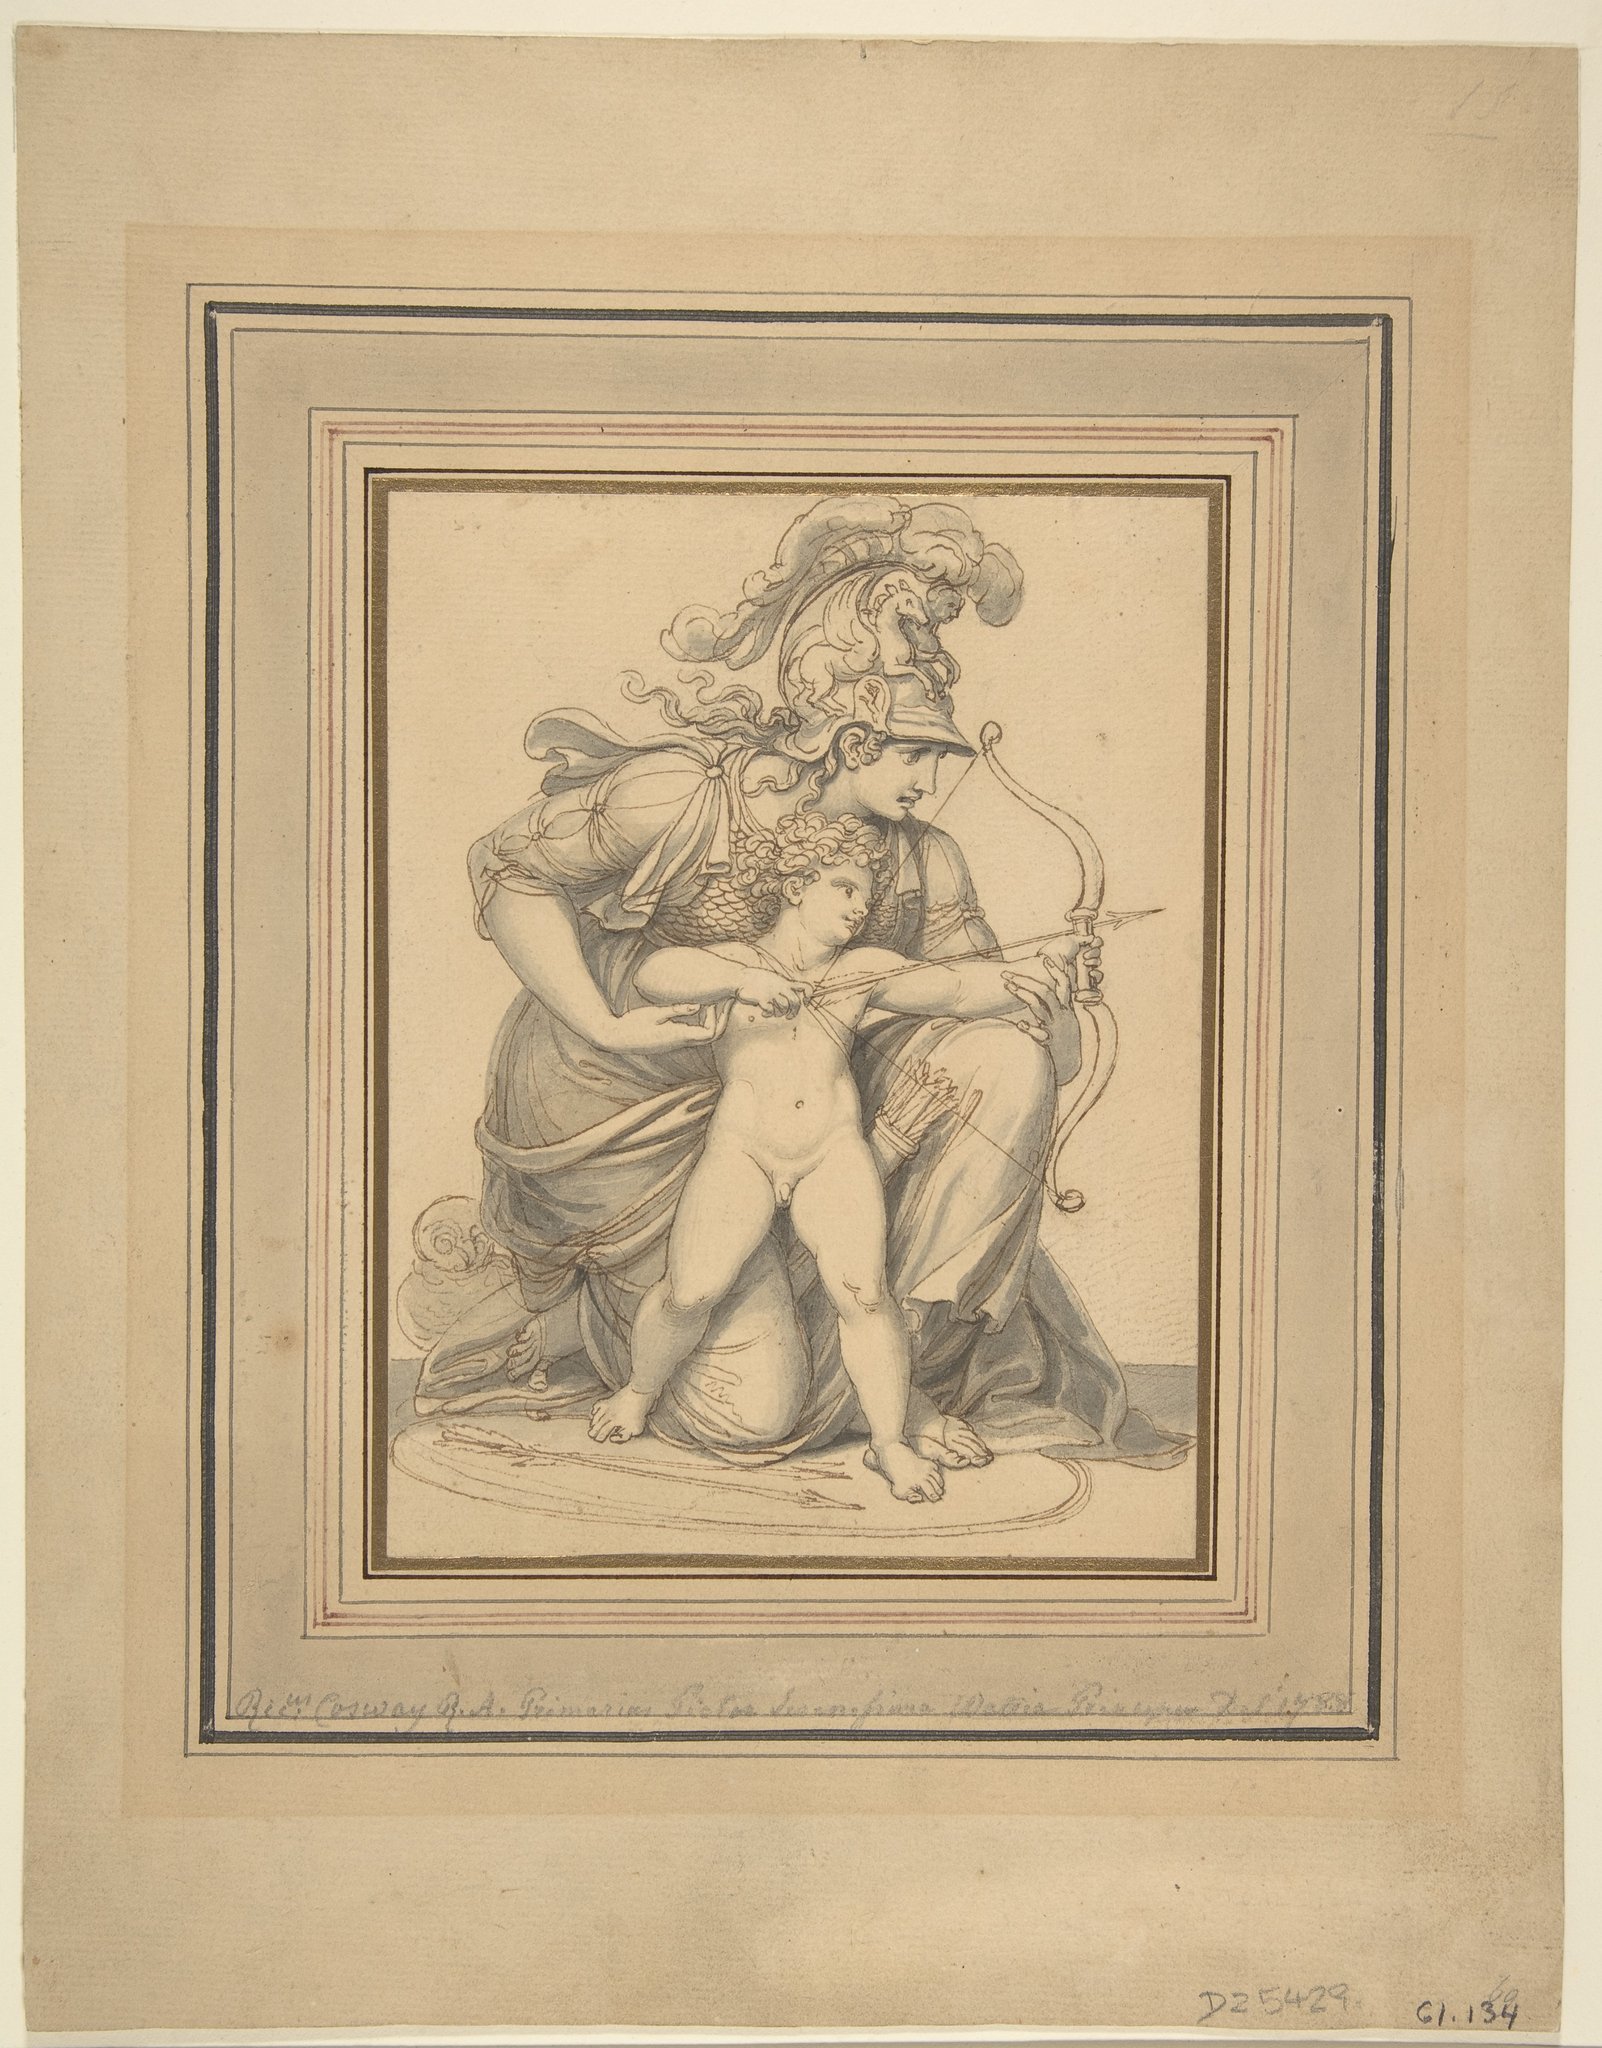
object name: drawing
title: Cupid and Minerva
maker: richard cosway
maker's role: artist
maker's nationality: british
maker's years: 1742-1821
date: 1788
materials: graphite, ink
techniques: brush, pen, wash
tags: bow and arrow,cupid,minerva